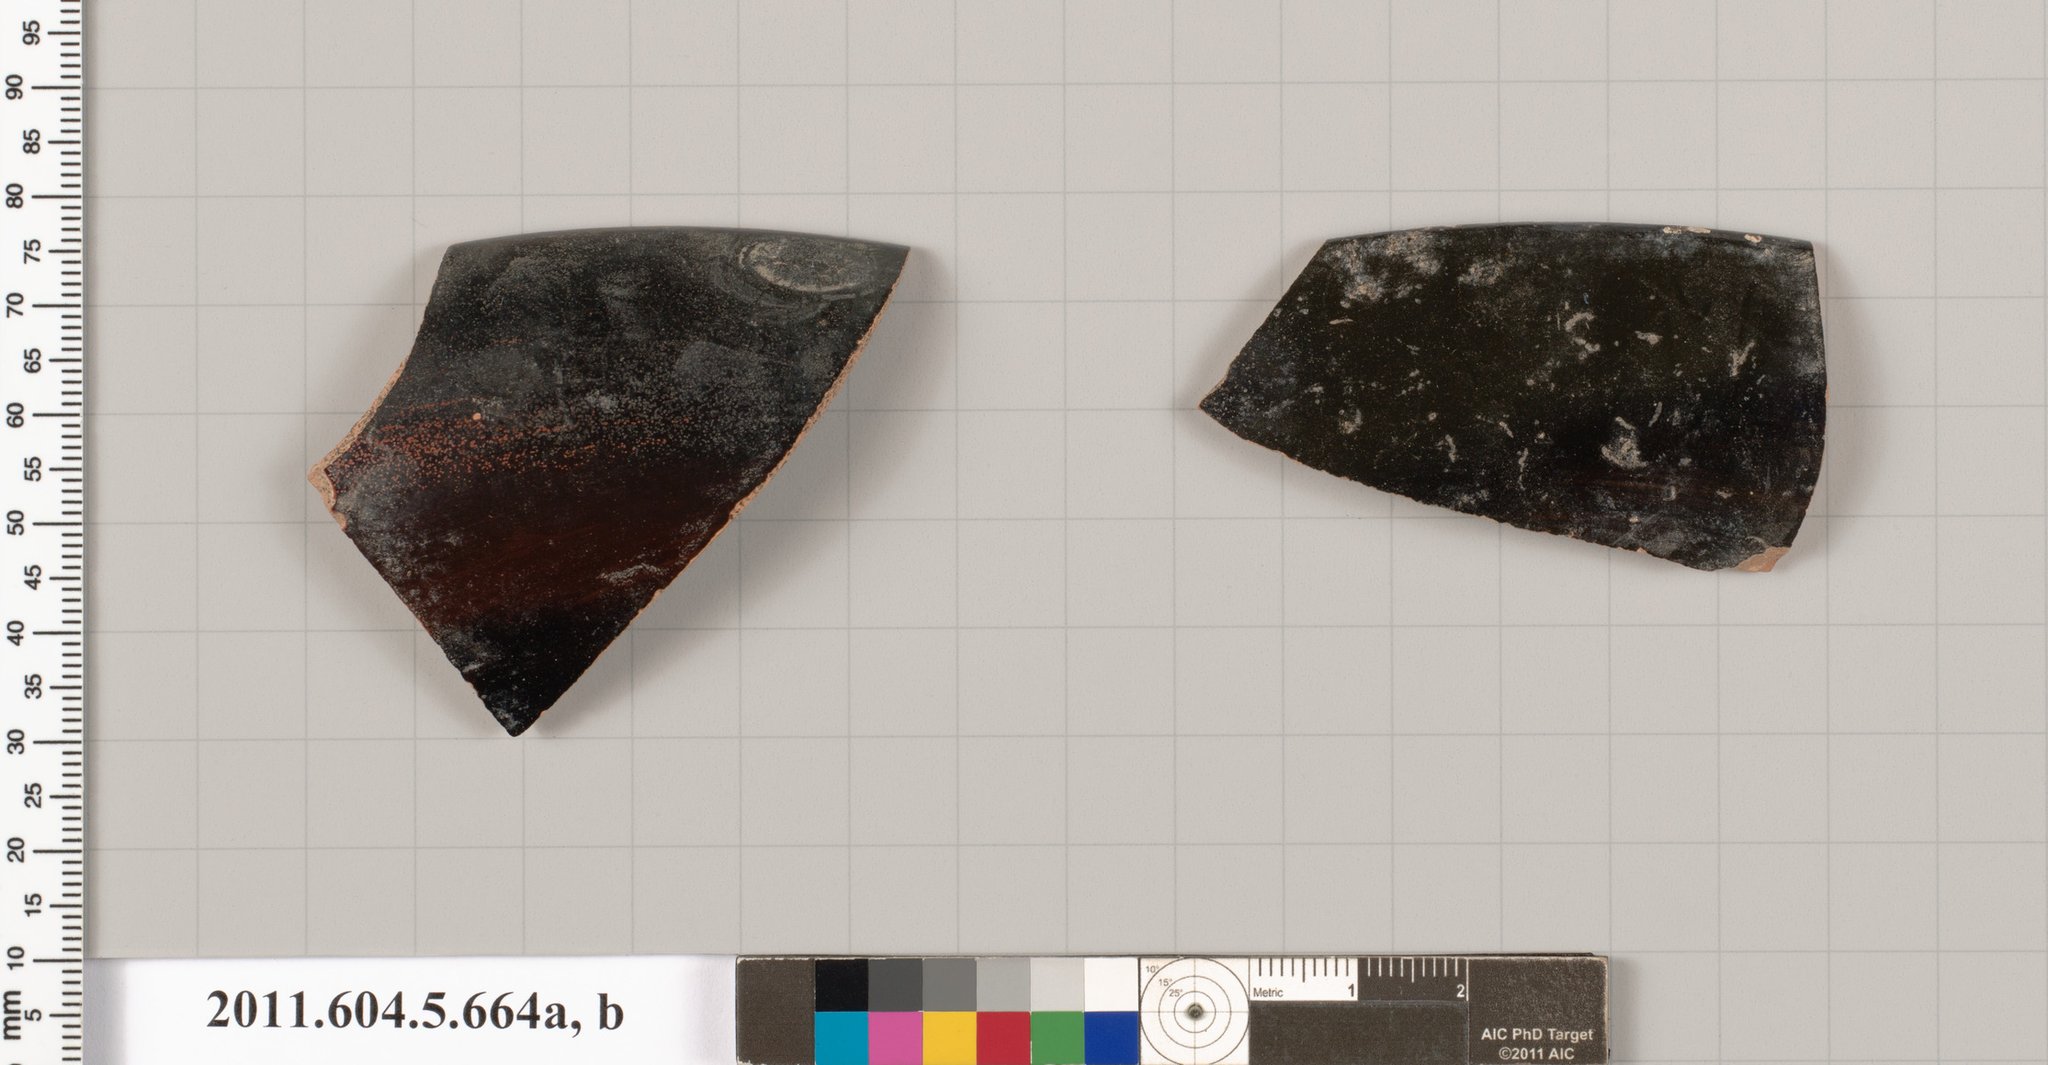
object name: kylix fragment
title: Terracotta rim fragments of kylikes (drinking cups)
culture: greek, attic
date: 600-401 BCE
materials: terracotta